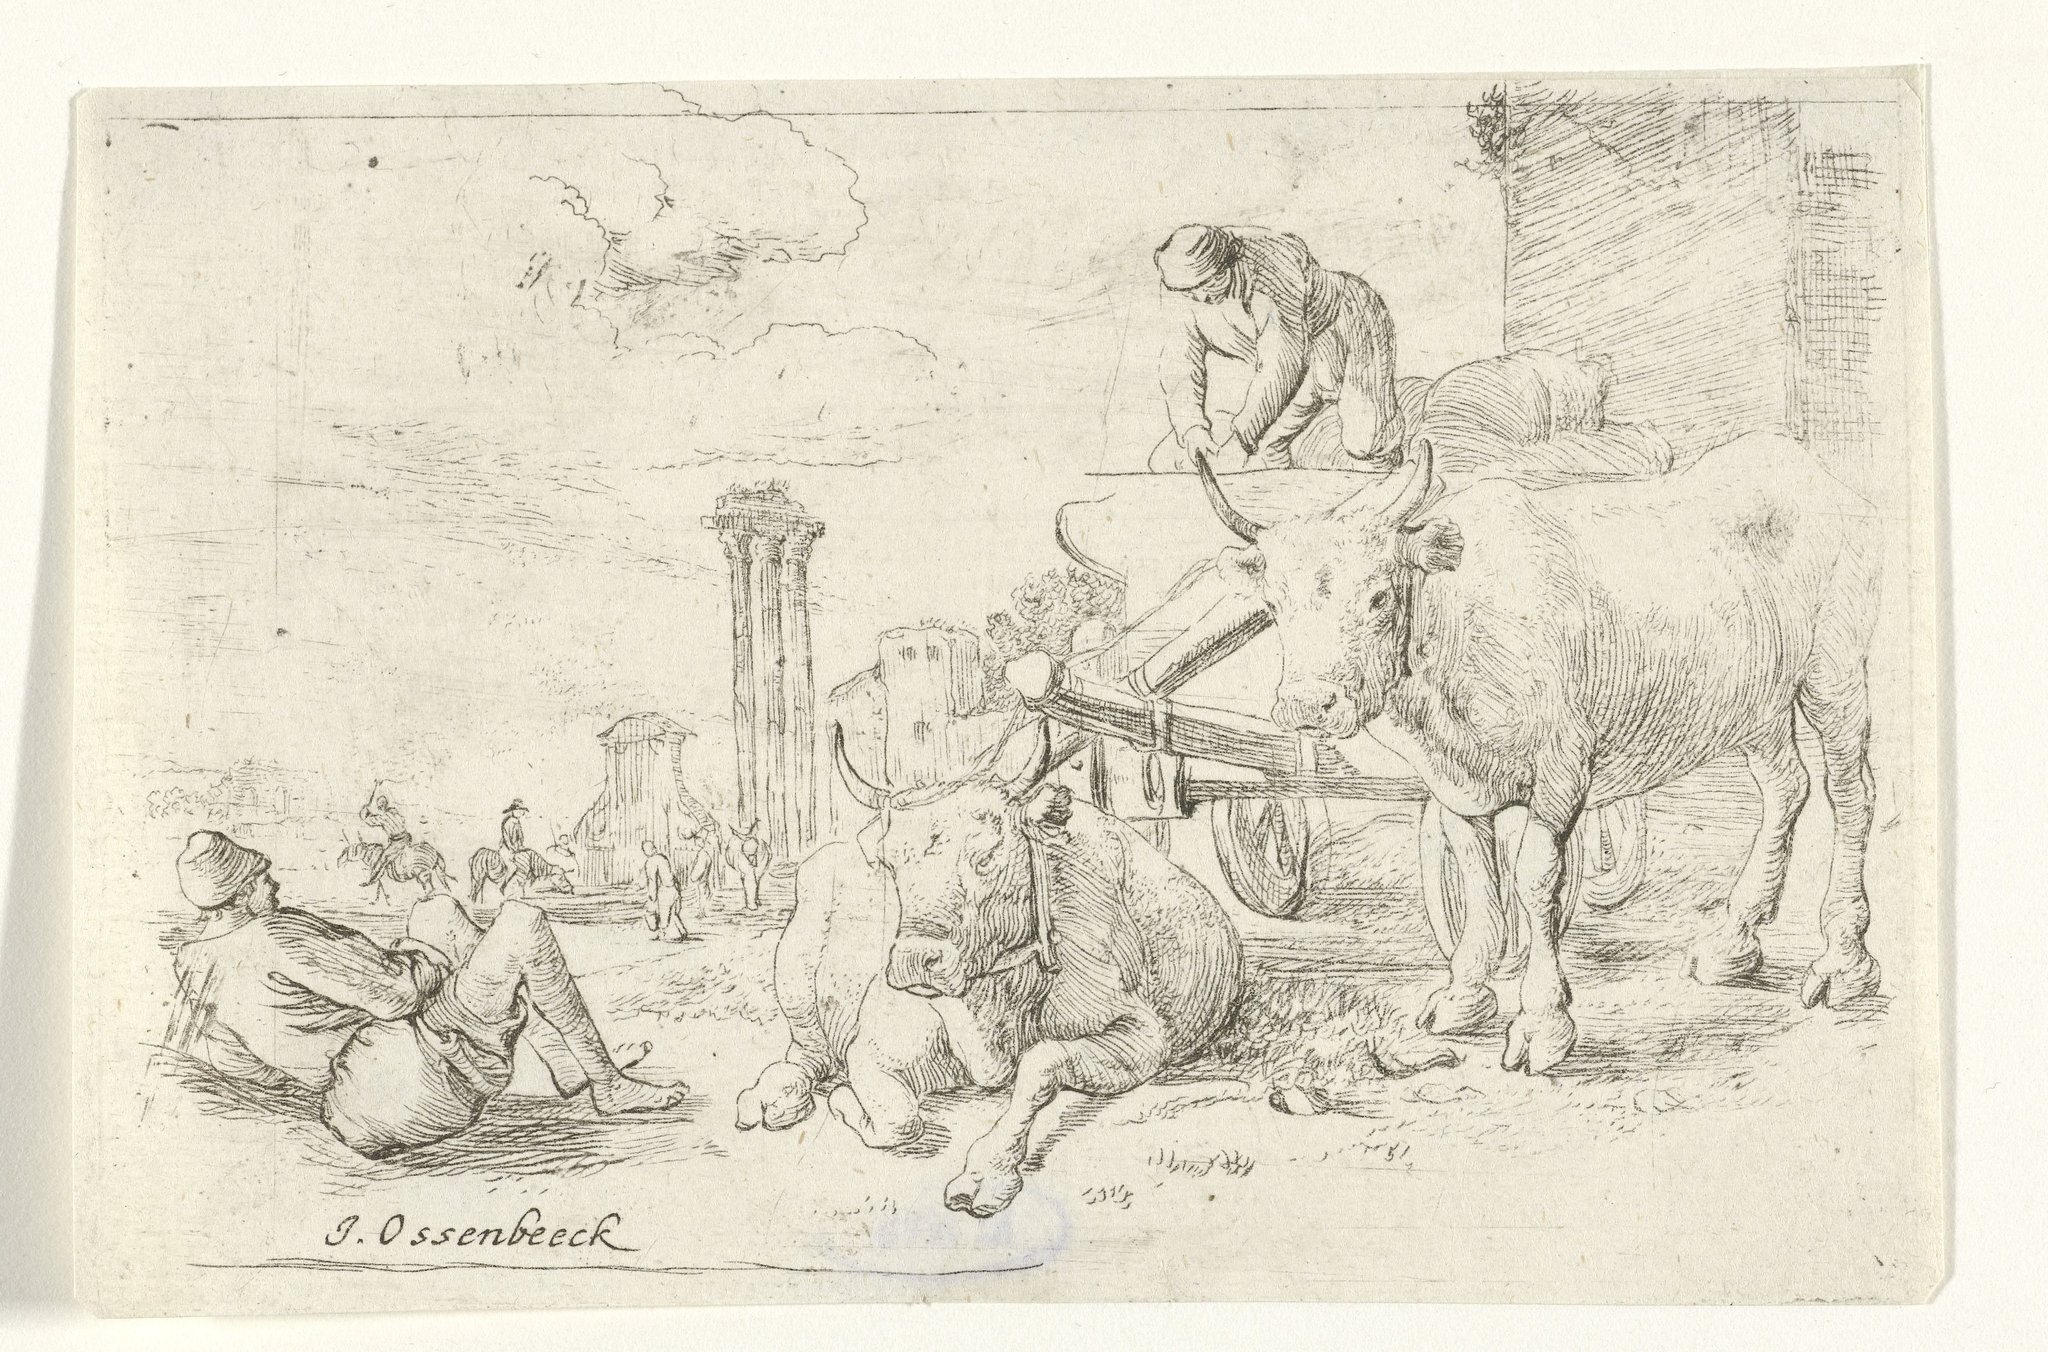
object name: print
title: Ossenkar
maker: jan van ossenbeeck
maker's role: print maker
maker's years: 1623-1674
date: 1647-1674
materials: paper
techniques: etching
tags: four-wheeled, animal-drawn vehicle, e.g.: cab, carriage, coach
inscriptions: collector's mark: Lugt 2610, collector's mark: Lugt 2228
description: Een liggende en een staande os voor een ossenkar. De kar wordt beladen door een boer. Op de achtergrond Romeinse ruïnes.